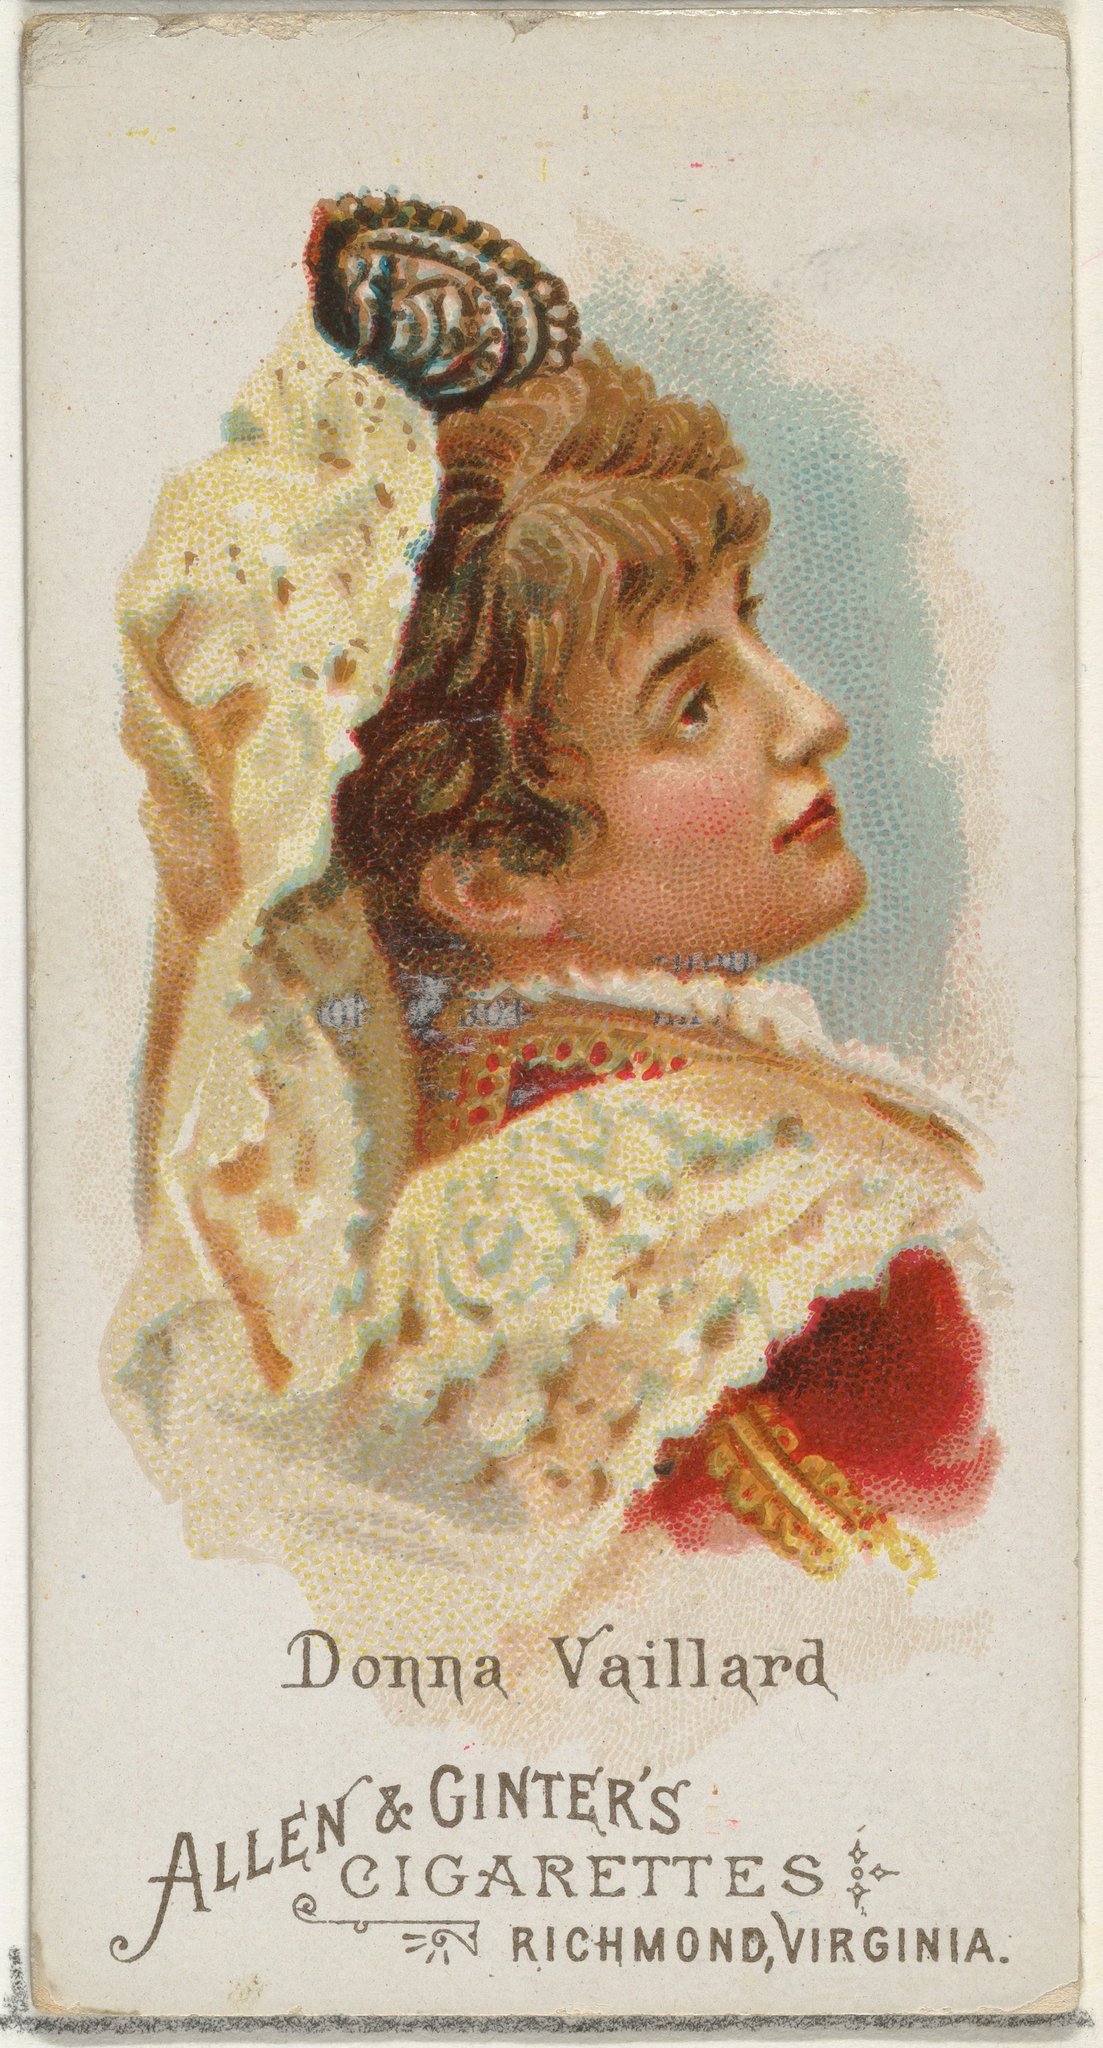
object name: print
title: Donna Vaillard, from World's Beauties, Series 1 (N26) for Allen & Ginter Cigarettes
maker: allen & ginter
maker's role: publisher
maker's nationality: american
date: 1888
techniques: color lithograph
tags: women